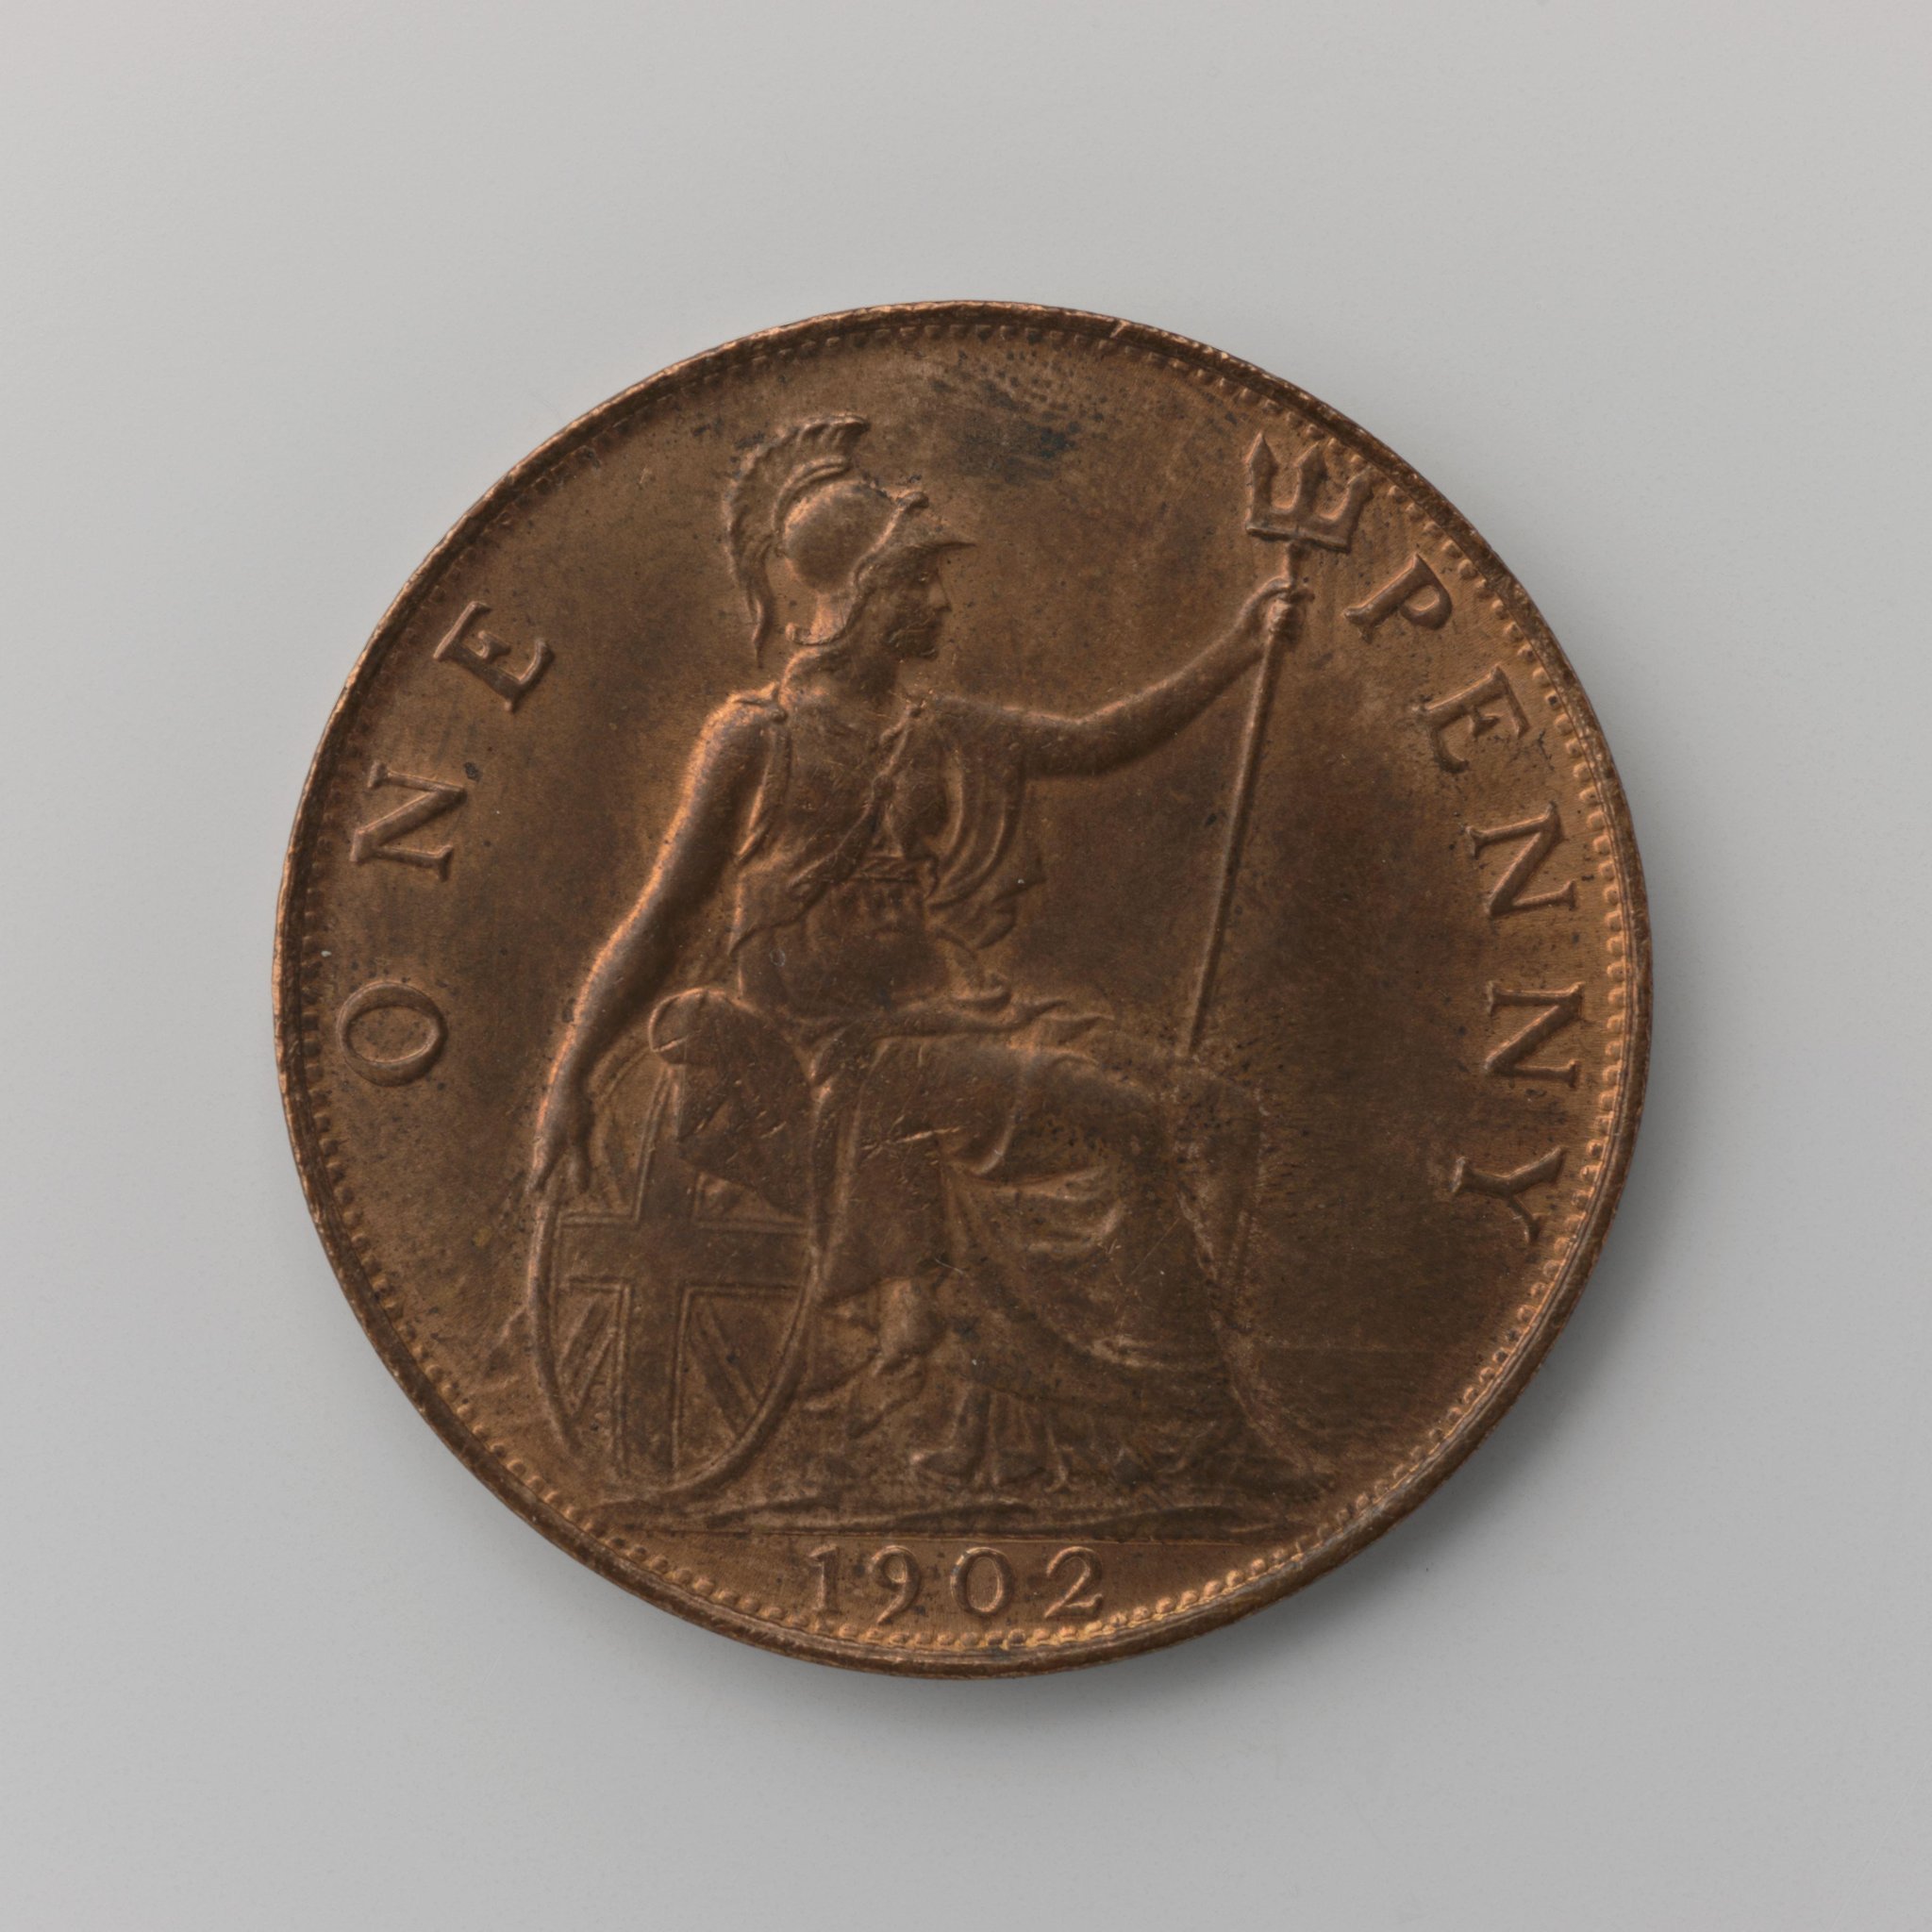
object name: coin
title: Engeland, Edward VII, penny, 1902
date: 1902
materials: bronze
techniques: striking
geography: london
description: Bronzen munt. Voorzijde:gekroond borstbeeld van de koning naar rechts. Keerzijde: door zee omgeven, tegen wapenschild gezeten Brittannia met drietand, naar rechts. In afsnede jaartal. Waarde-aanduiding als omschrift. Gladde rand.